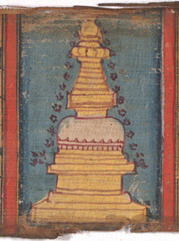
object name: folio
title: Folio from a Manuscript of the Ashtasahasrika Prajnaparamita (Perfection of Wisdom)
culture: indian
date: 1101-1200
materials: ink, leaf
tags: buddhism,stupas